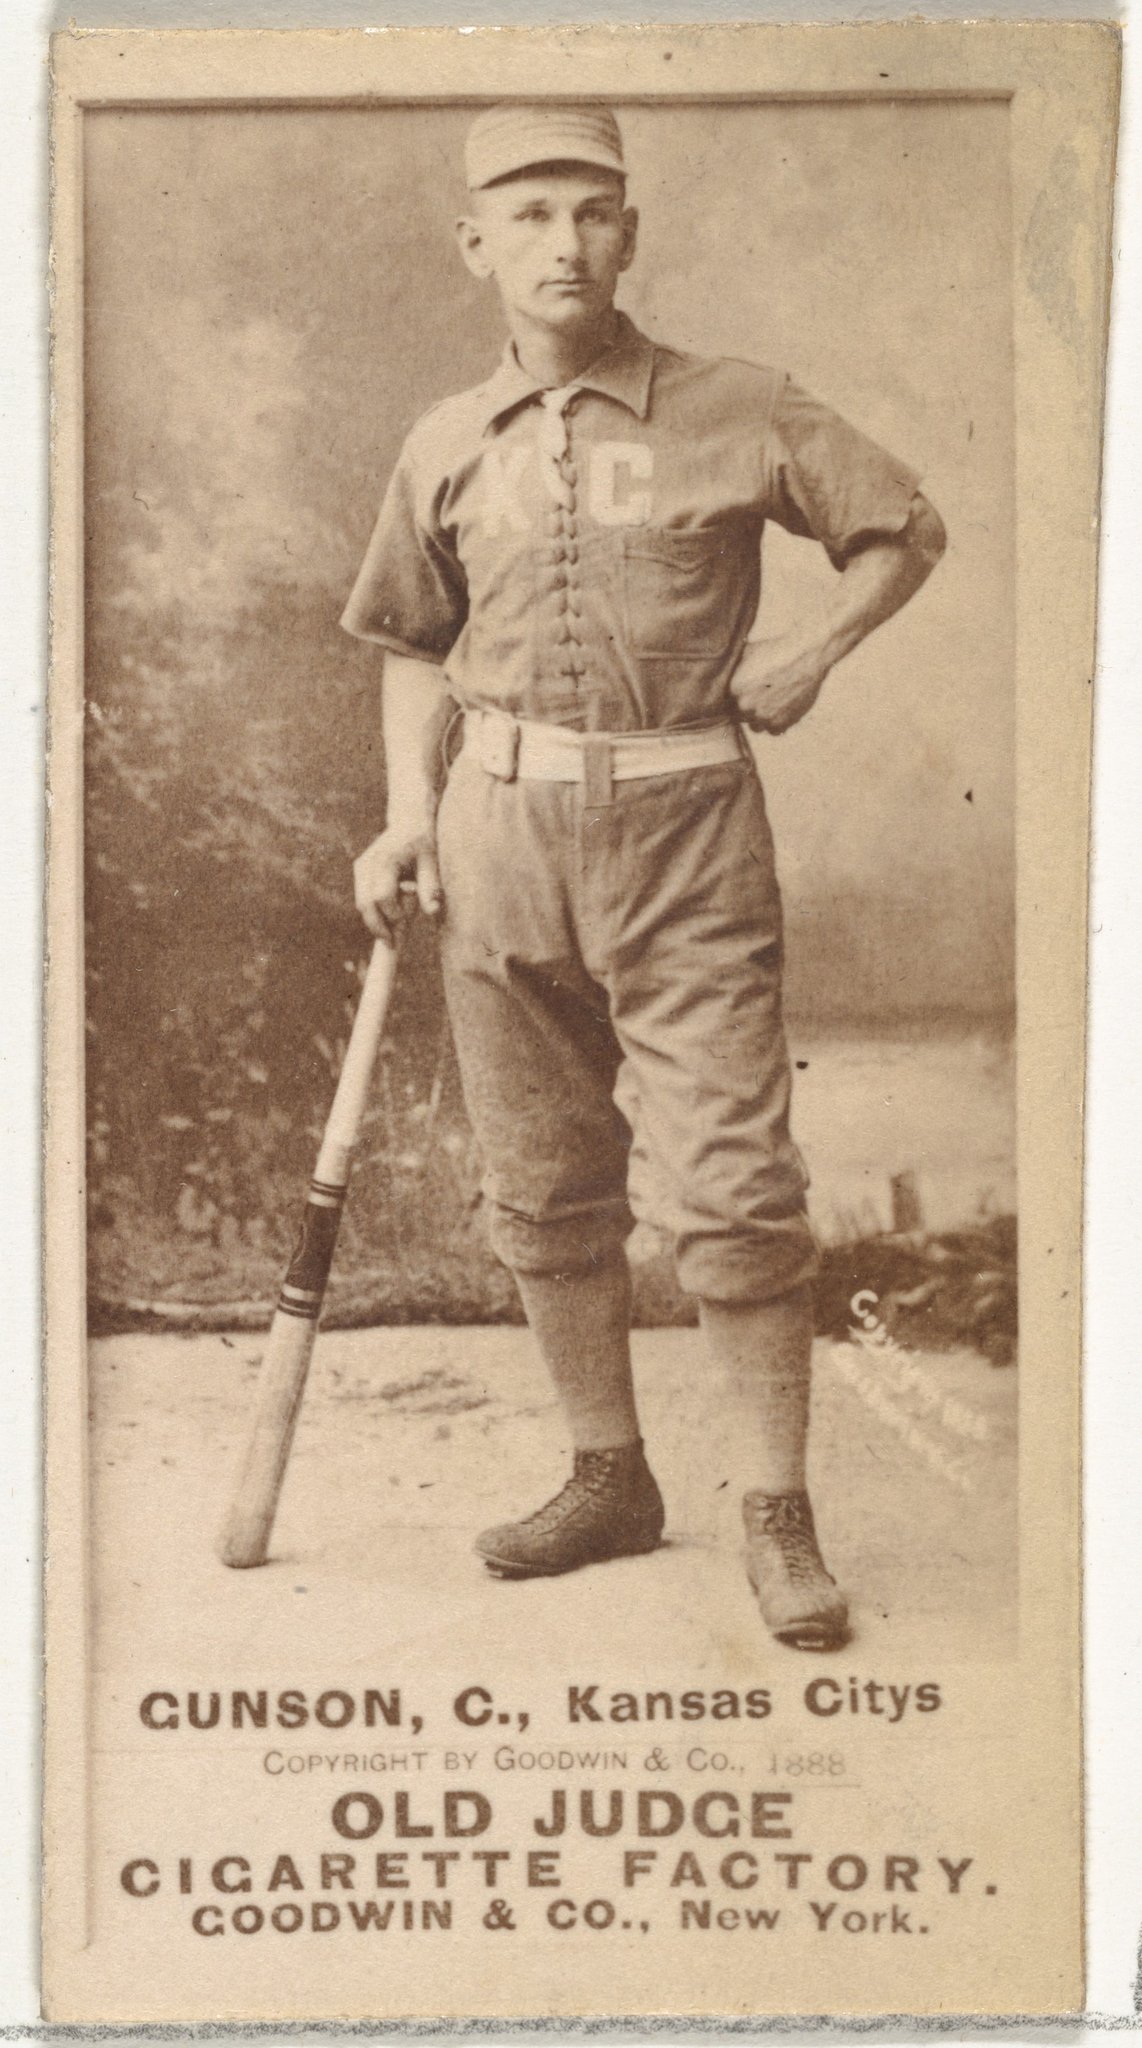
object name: baseball card, photograph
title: Joseph Brook "Joe" Gunson, Catcher, Kansas City Cowboys, from the Old Judge series (N172) for Old Judge Cigarettes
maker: goodwin & company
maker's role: publisher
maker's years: 1850-1950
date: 1888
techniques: albumen silver print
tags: men,portraits,baseball,athletes